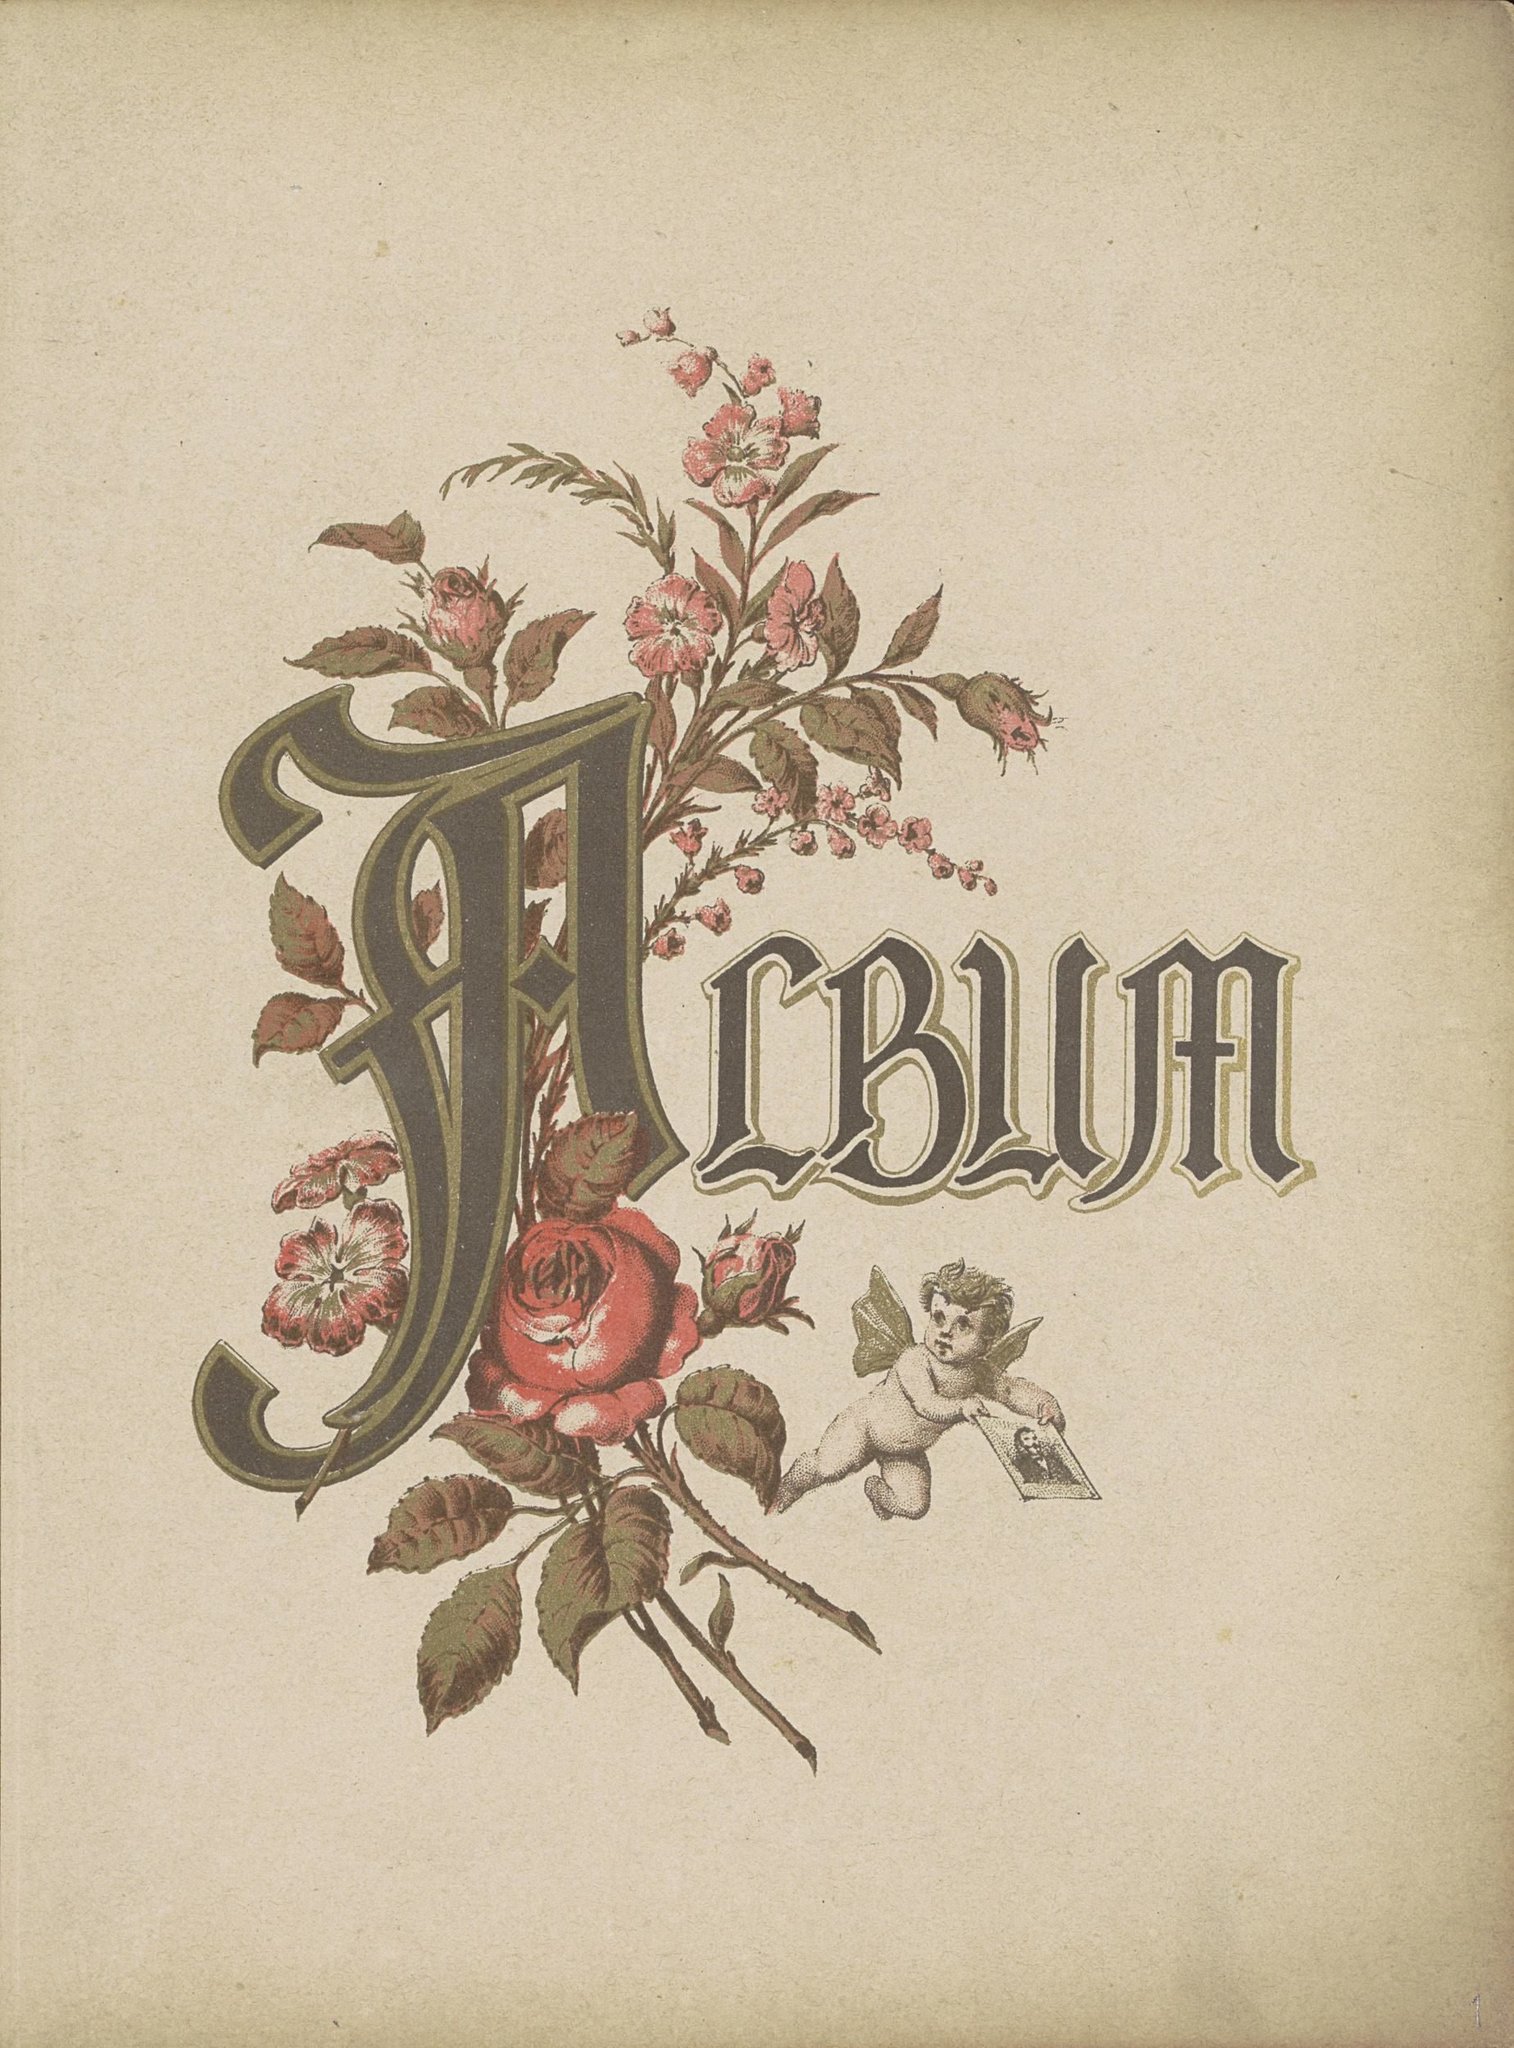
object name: album leaf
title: Titelblad met een boeket en een putto met een foto in de handen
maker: Anonymous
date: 1860-1900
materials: paper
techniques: letterpress printing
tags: flowers, angel(s) represented as child(ren)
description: Onderdeel van Fotoalbum van een Nederlandse familie met 168 cartes-de-visite en kabinetfoto's.